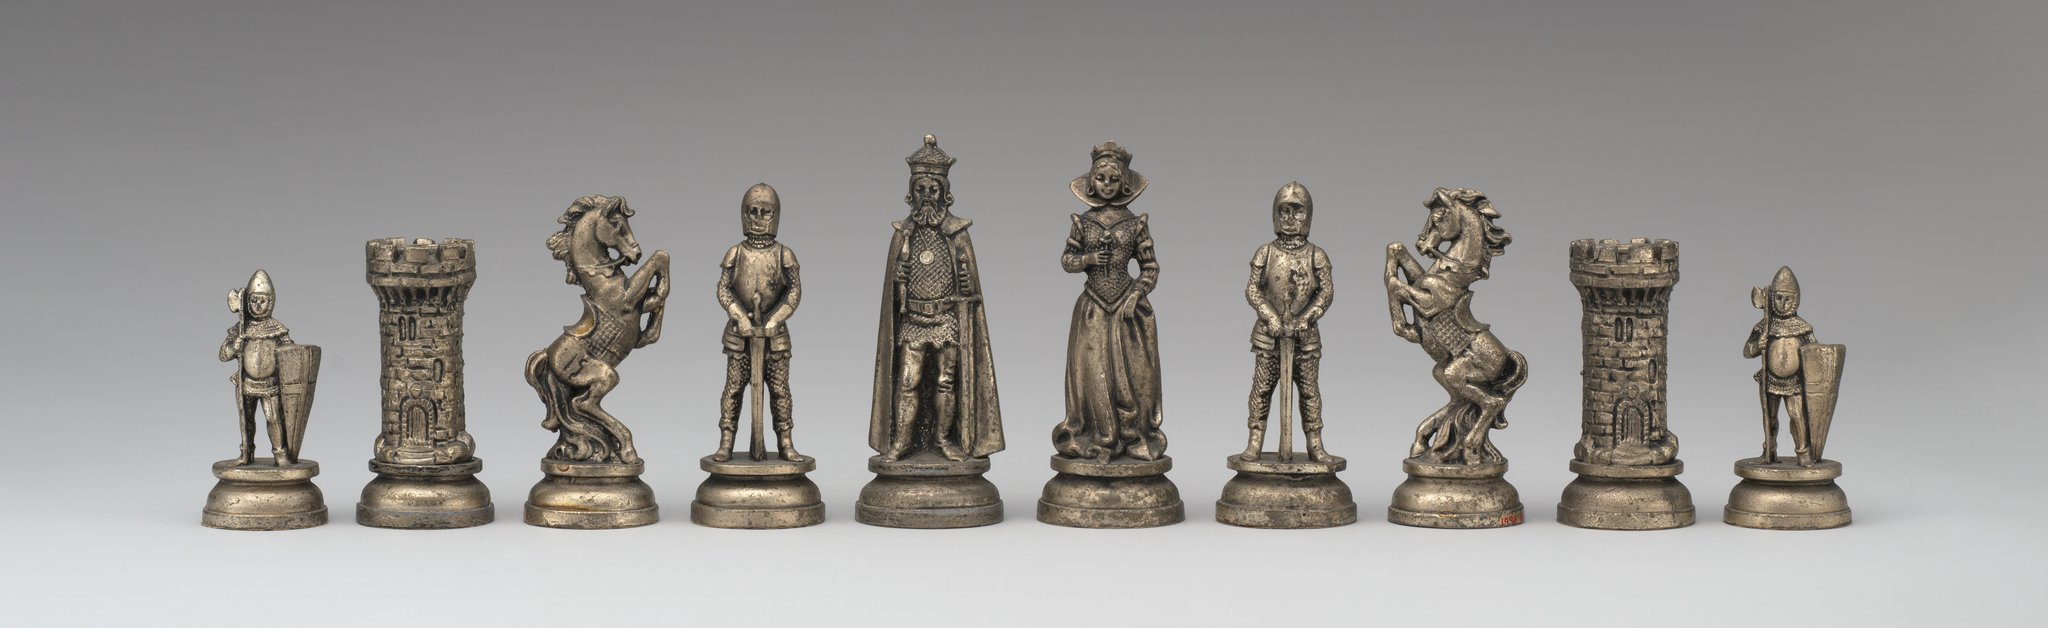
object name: chessman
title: Chessmen (32)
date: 1850-1860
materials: metal